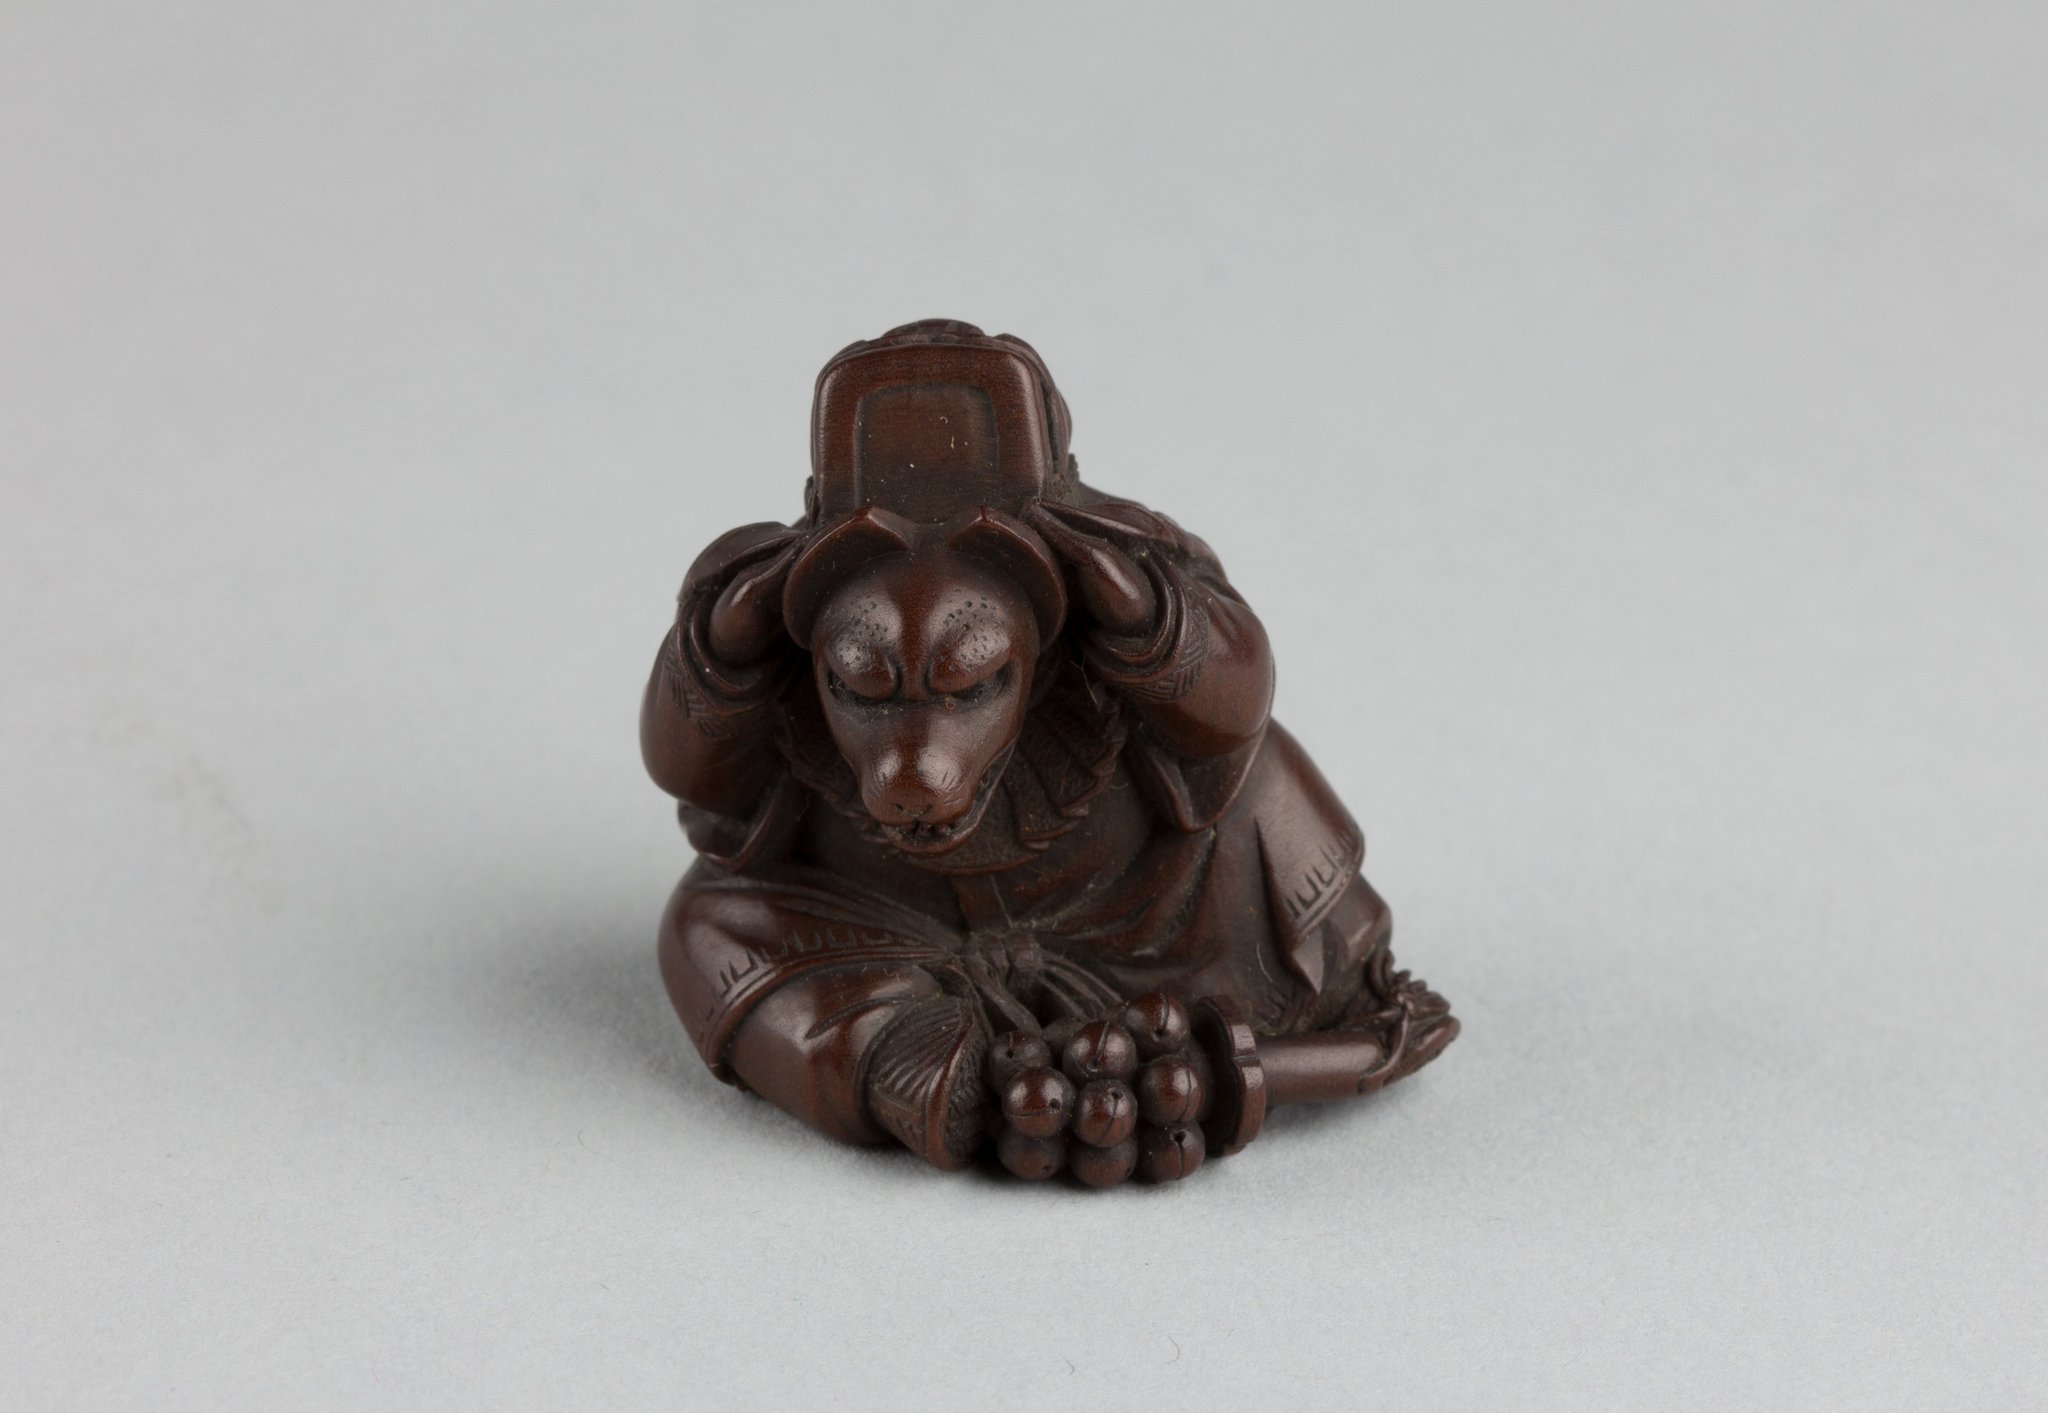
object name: netsuke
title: Netsuke of Fox Disguised as Shishimai Dancer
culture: japanese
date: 1801-1900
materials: wood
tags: foxes,dancers